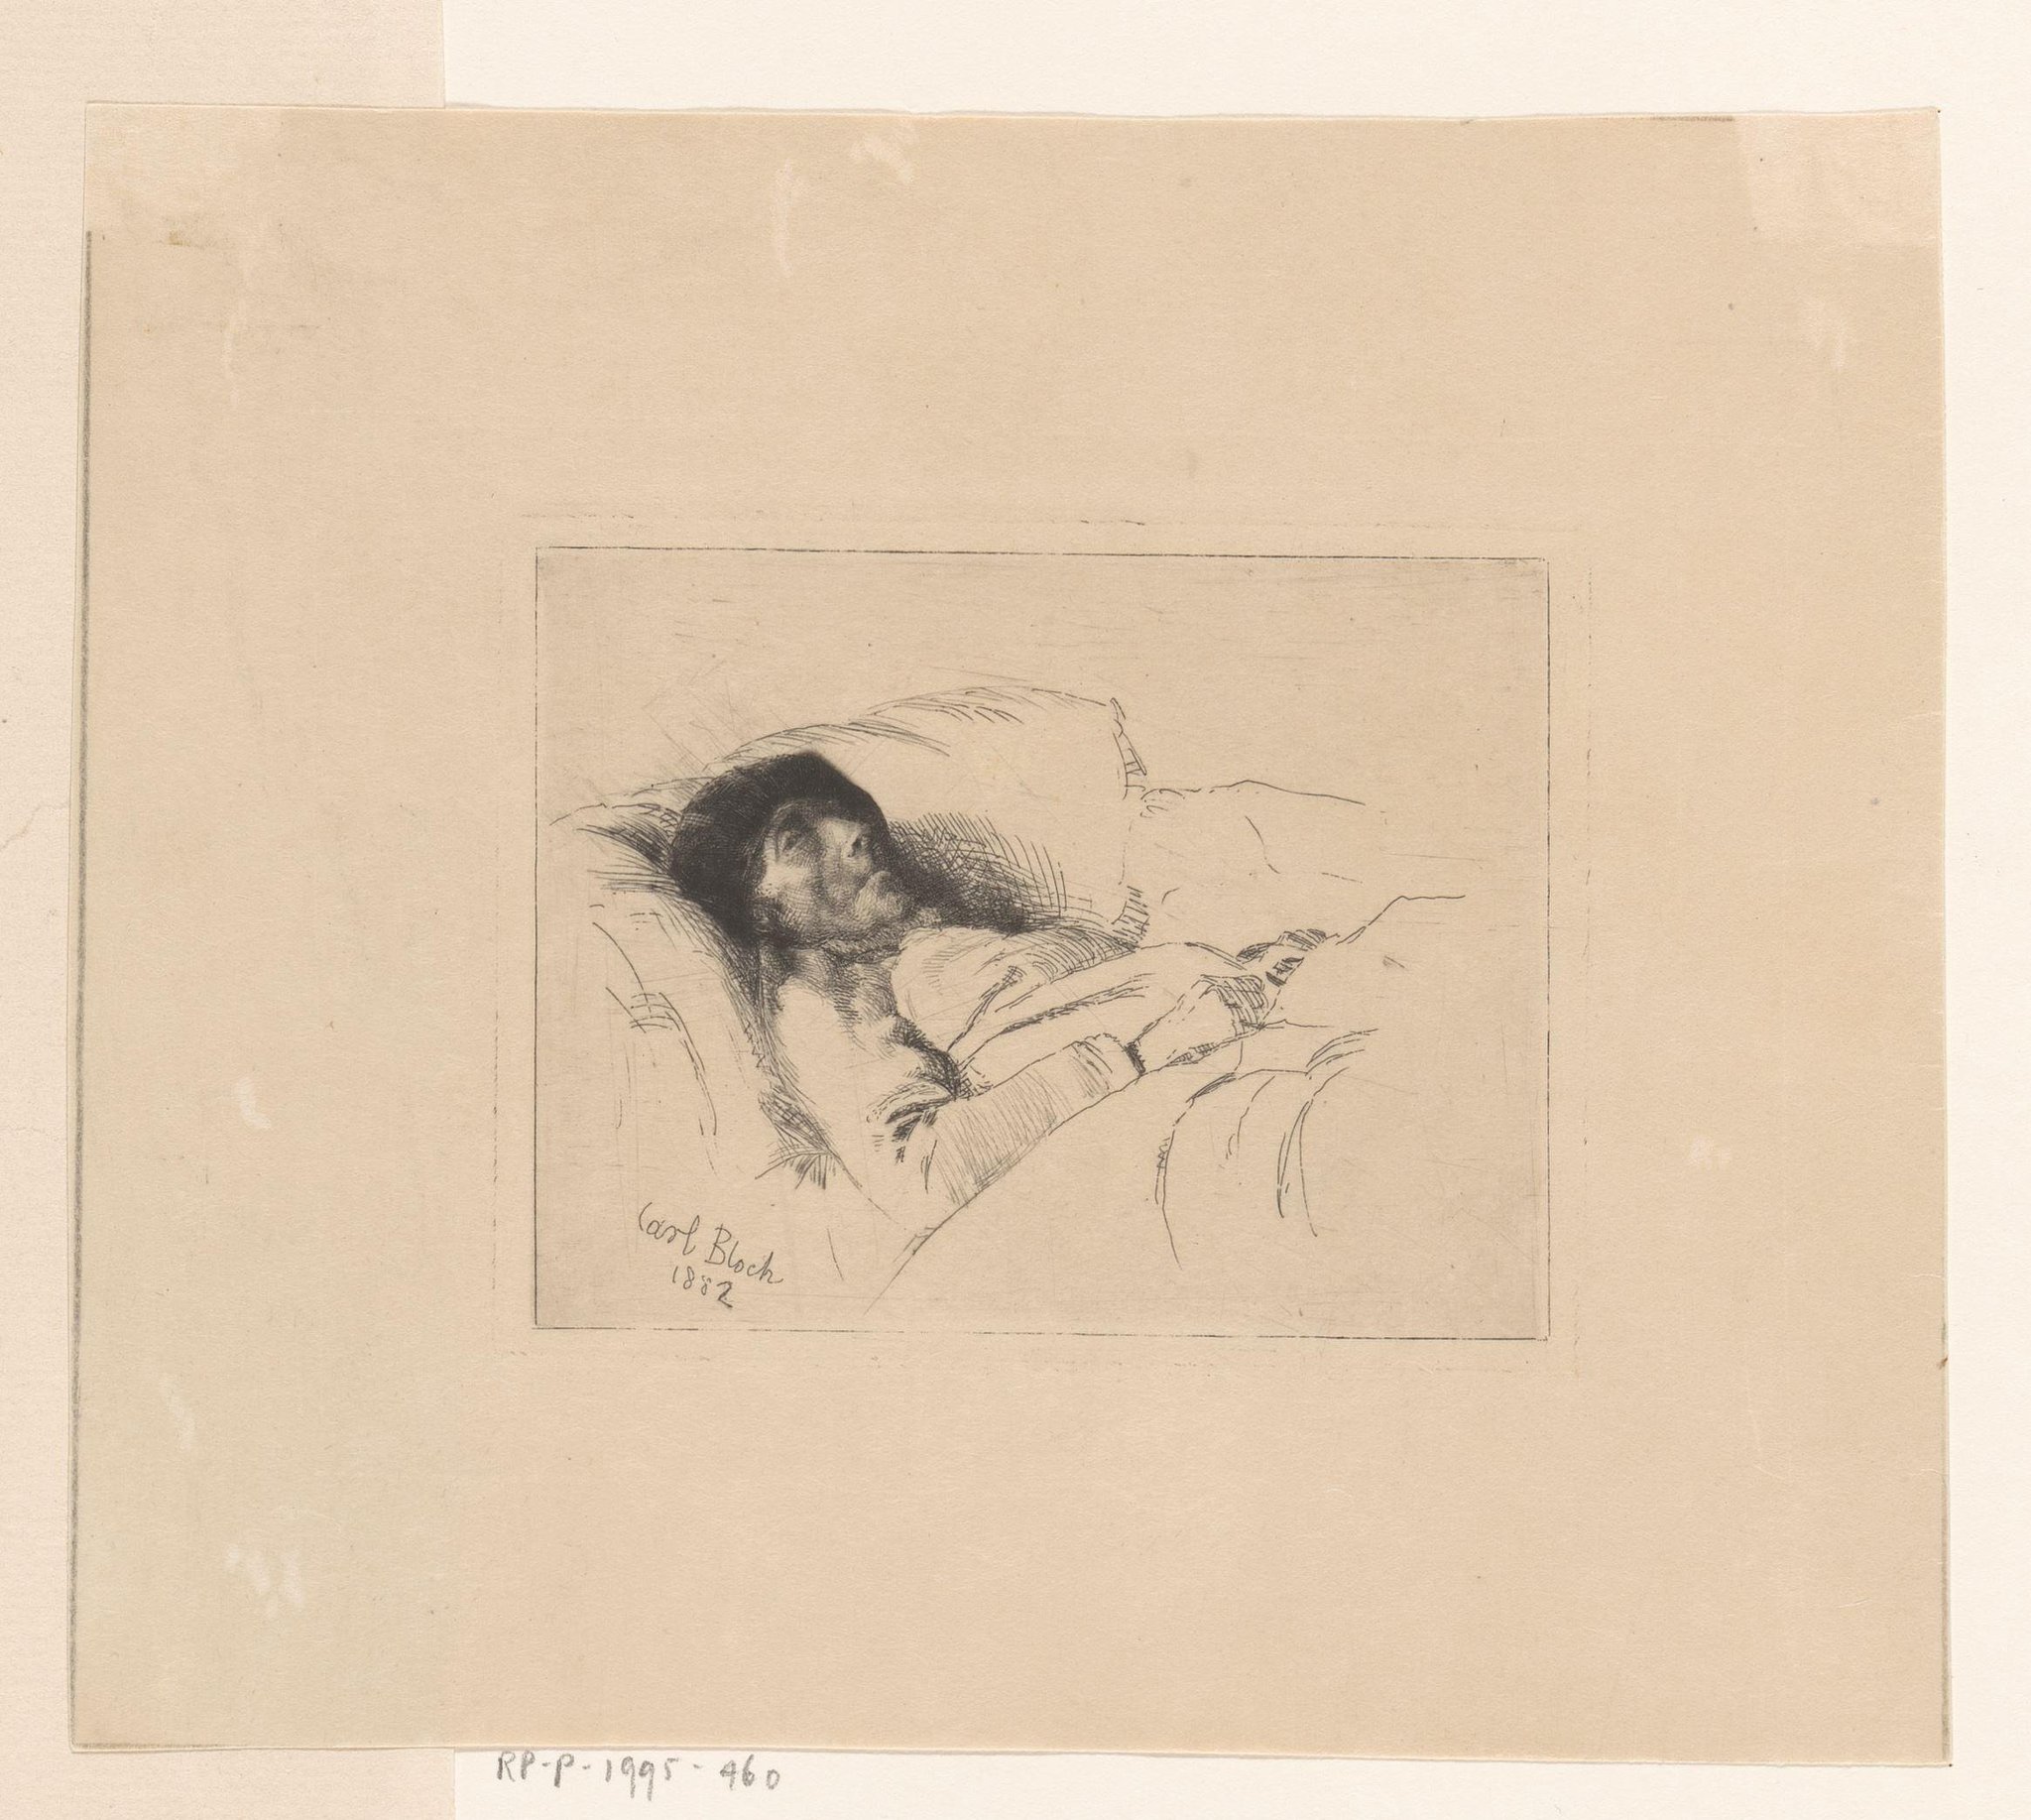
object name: print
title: Oude vrouw in bed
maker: carl bloch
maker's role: print maker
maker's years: 1834-1890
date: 1882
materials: paper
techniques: drypoint, etching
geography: scandinavia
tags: old woman, bed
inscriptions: collector's mark: Lugt 2228, signature and date: ‘l.o. gesigneerd en gedateerd Carl Bloch 1882’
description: Oude vrouw (of man?) met muts op in bed liggend, de beschouwer aankijkend.